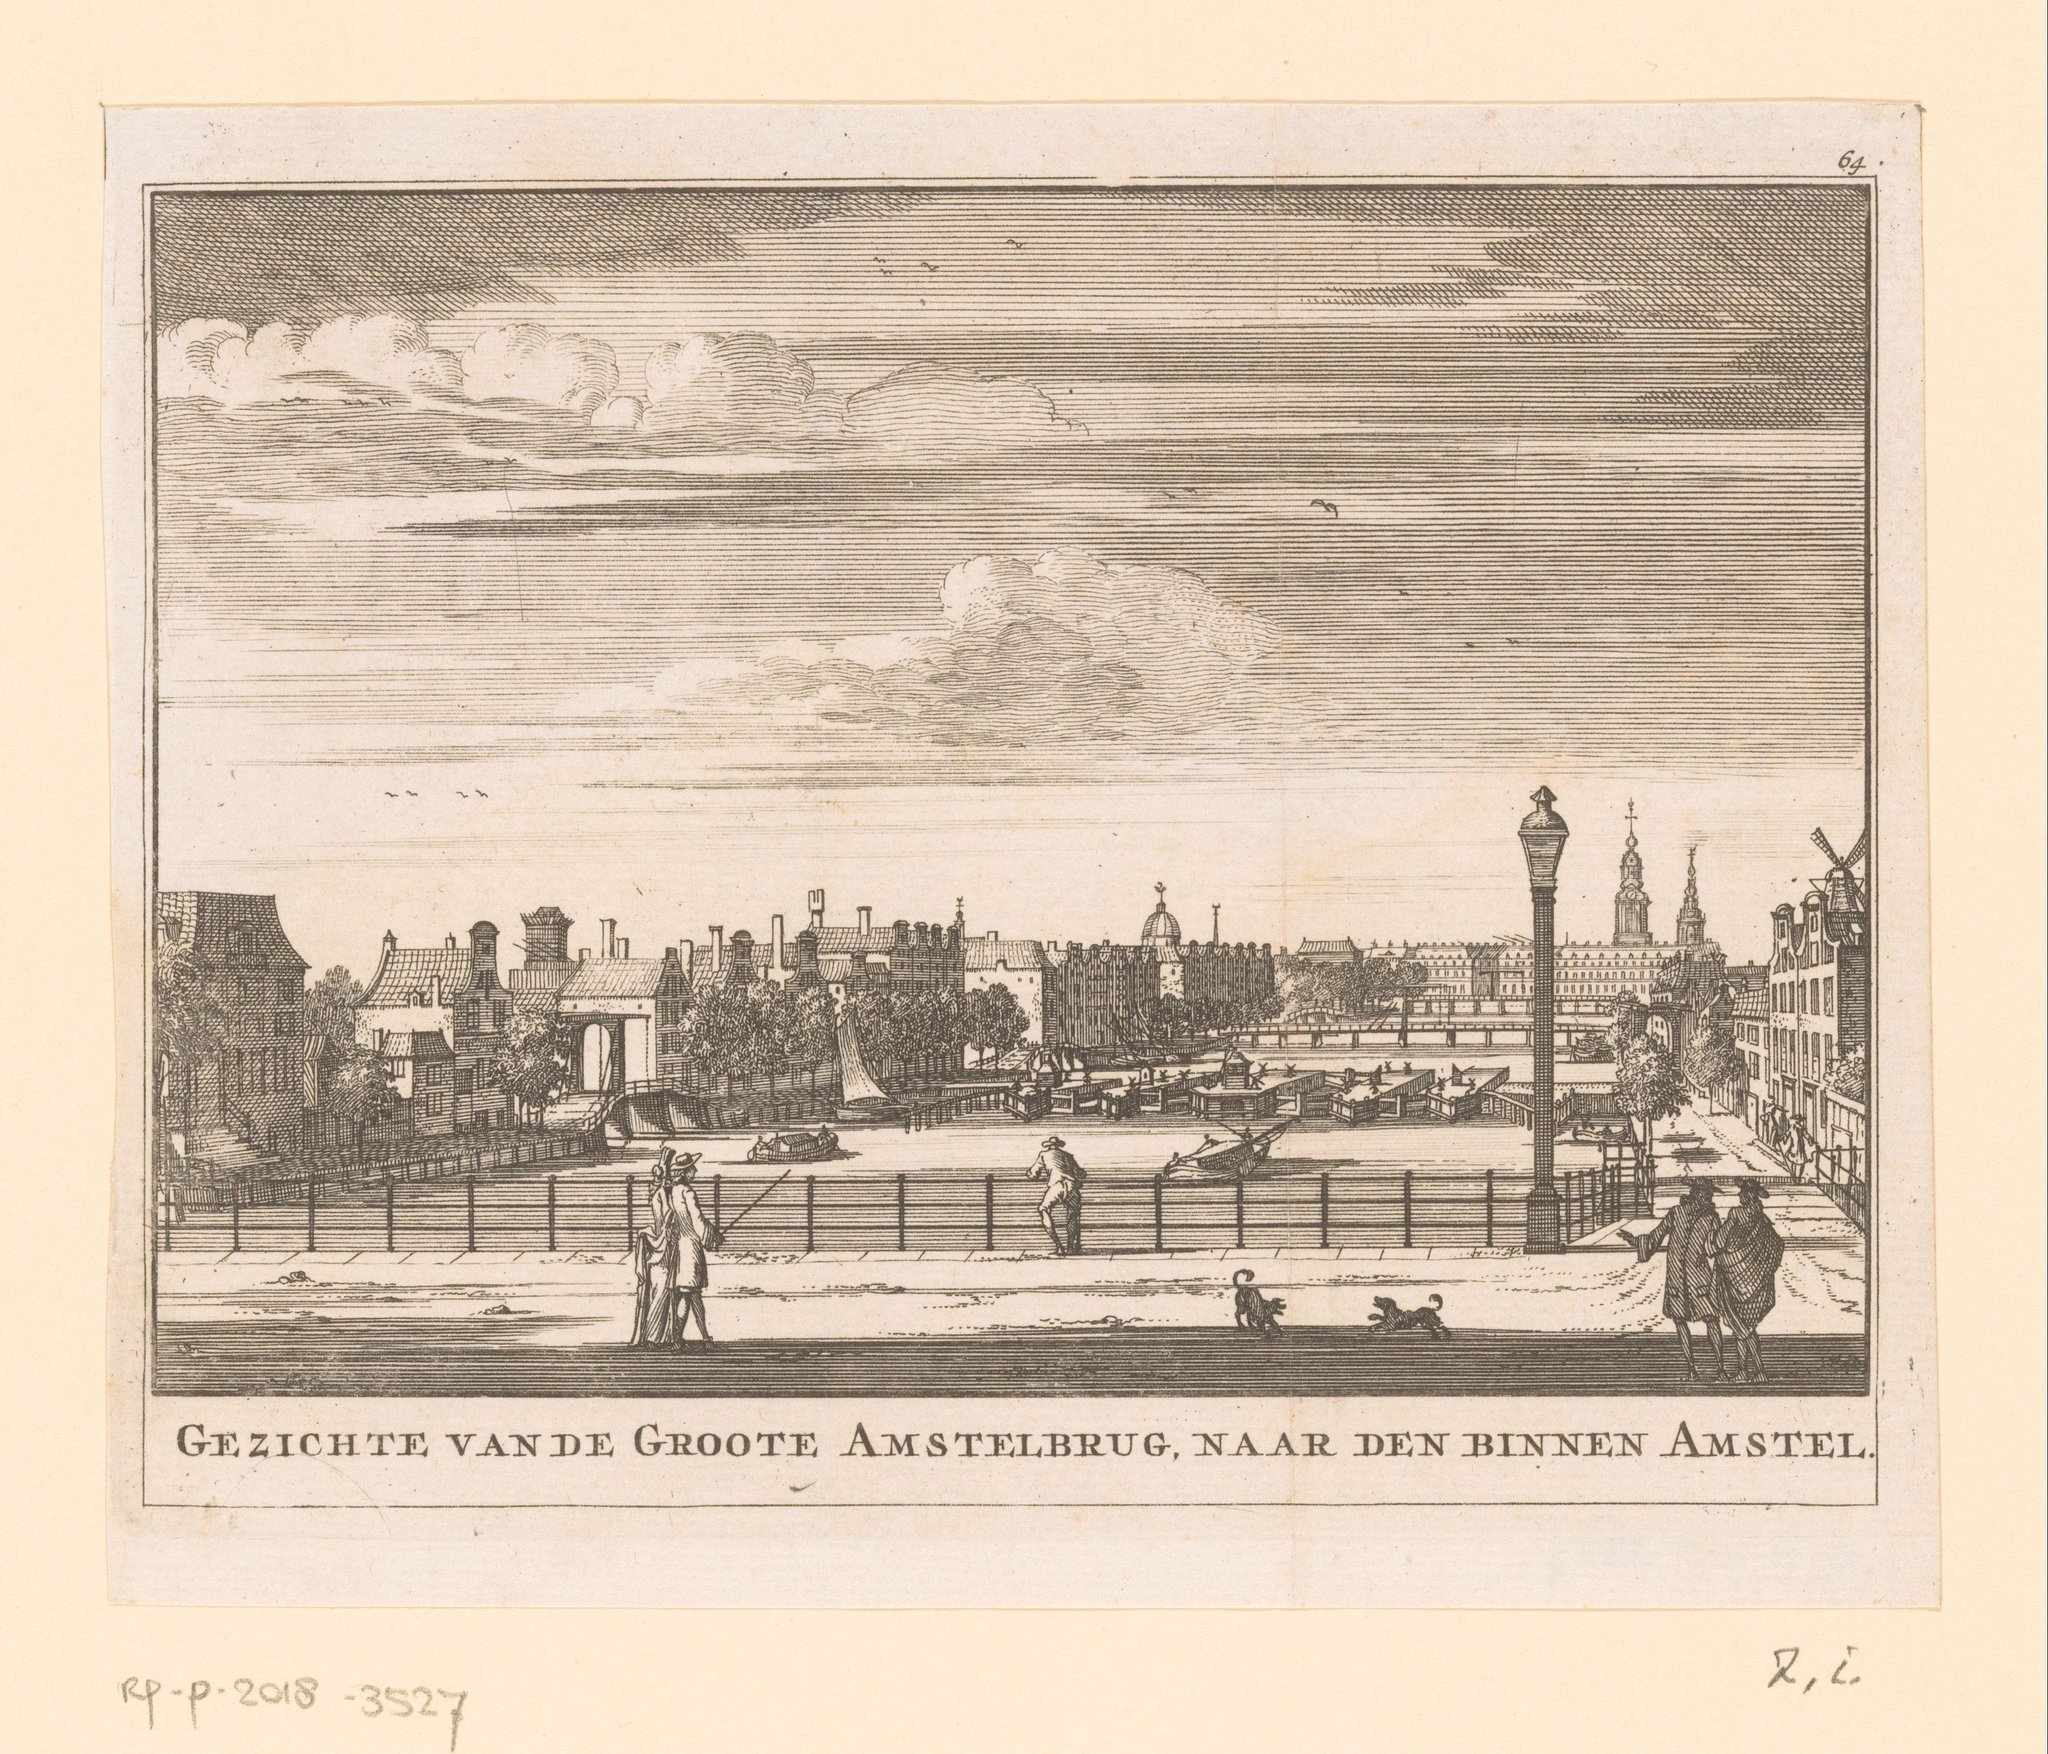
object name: print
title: Gezicht op de Binnen Amstel in Amsterdam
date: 1726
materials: paper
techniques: engraving, etching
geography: amsterdam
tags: canals, waters (in city), bridge in city across river, canal, etc.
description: Tweede staat van prent genummerd 59 gebruikt in: Hoorn, Nicolaas ten. Wegwyzer door Amsterdam zynde eene beknopte verhandeling van desselfs eerste opkomft, vergrootingen, en teegenwoordigen staat. Amsterdam: Nicolaas ten Hoorn, 1713. Derde staat van prent genummerd 63 gebruikt in: Hoorn, Nicolaas ten. Wegwyzer door Amsterdam, Zynde eene beknopte verhandeling van desselfs eerste opkomst, vergrootingen, en teegenwoordigen staat (…). Tweede druk. Amsterdam: Nicolaas ten Hoorn, 1726, p. 65. En in de latere edities (Amsterdam: erven J. Ratelband & Co, 1737, en Amsterdam: Pieter Meyer, 1751).